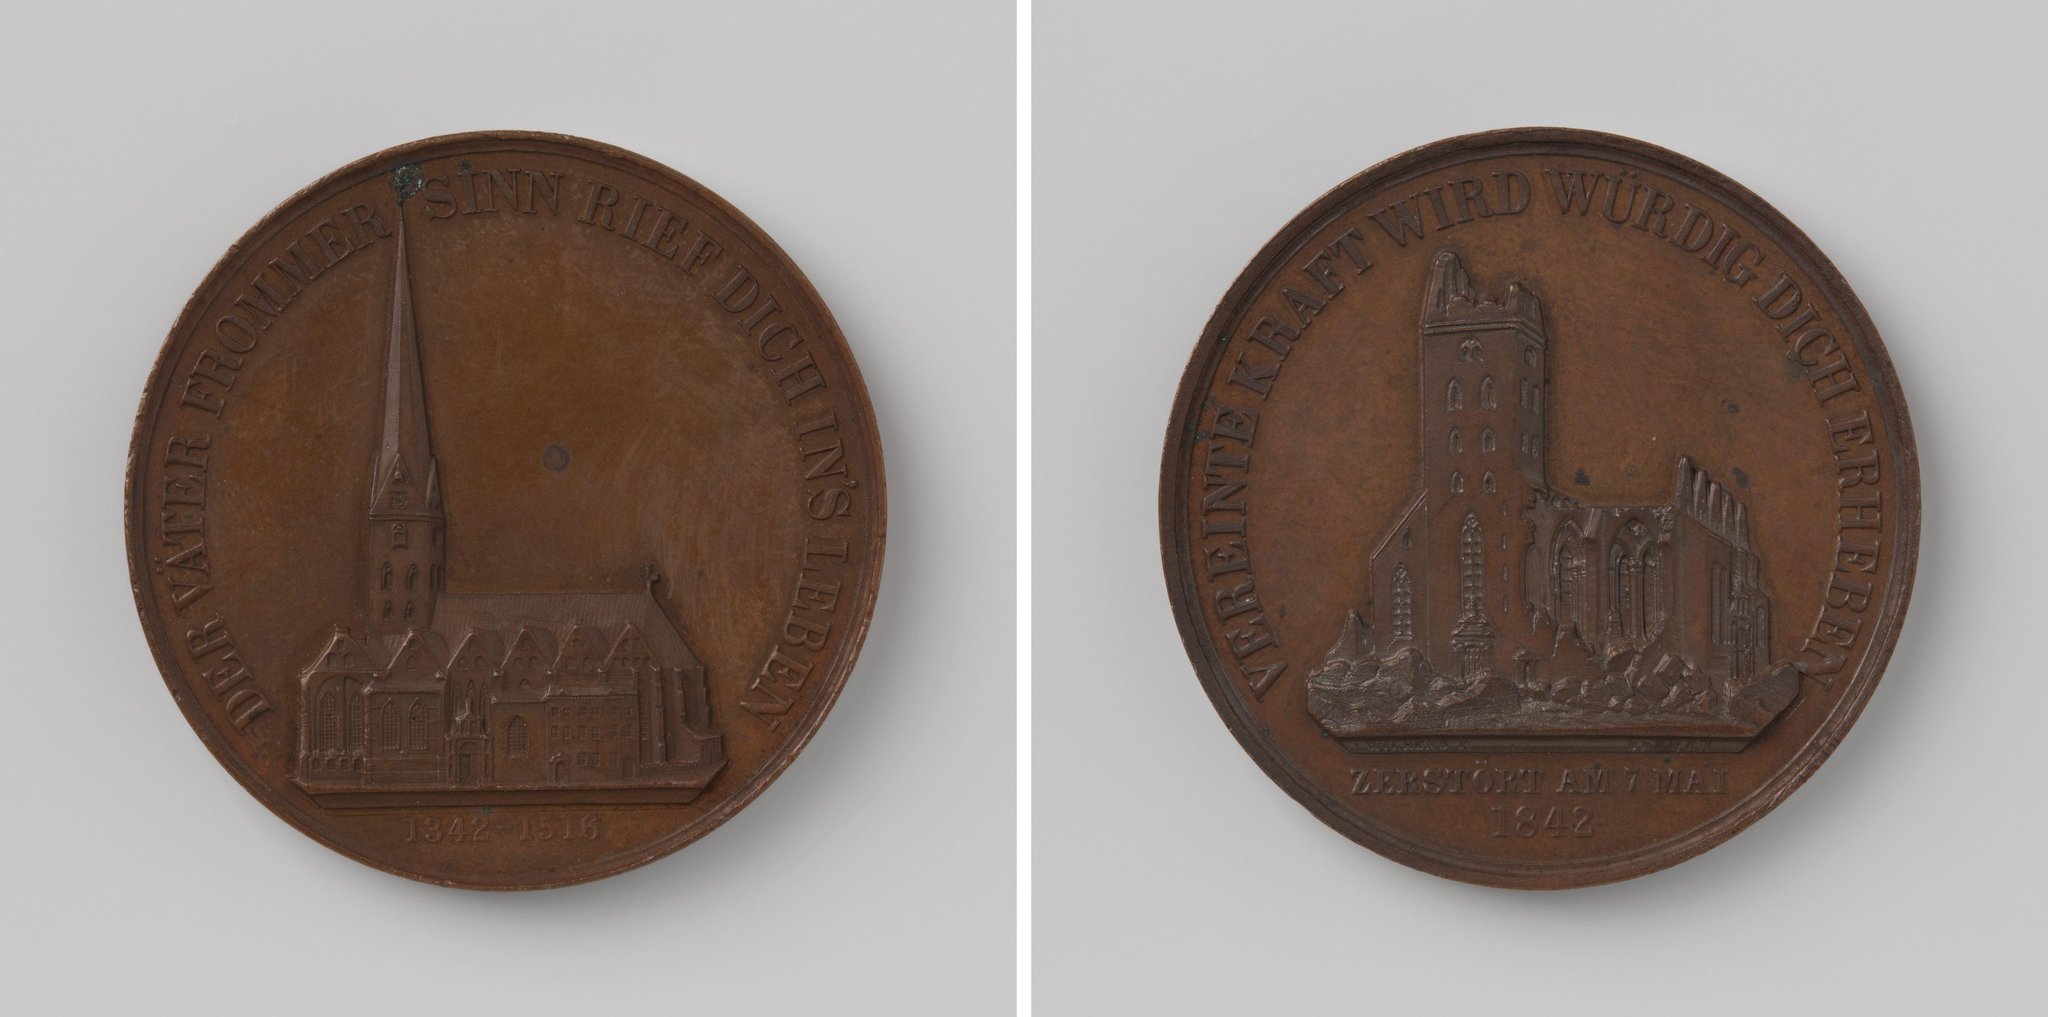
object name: history medal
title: Brand van de St. Peterskerk te Hamburg, penning geslagen uit het koper afkomstig van de kerktoren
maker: marten heinrich wilkens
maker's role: goldsmith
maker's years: 1782-1869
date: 1842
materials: copper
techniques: engraving, striking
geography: bremen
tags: sint-peterskerk